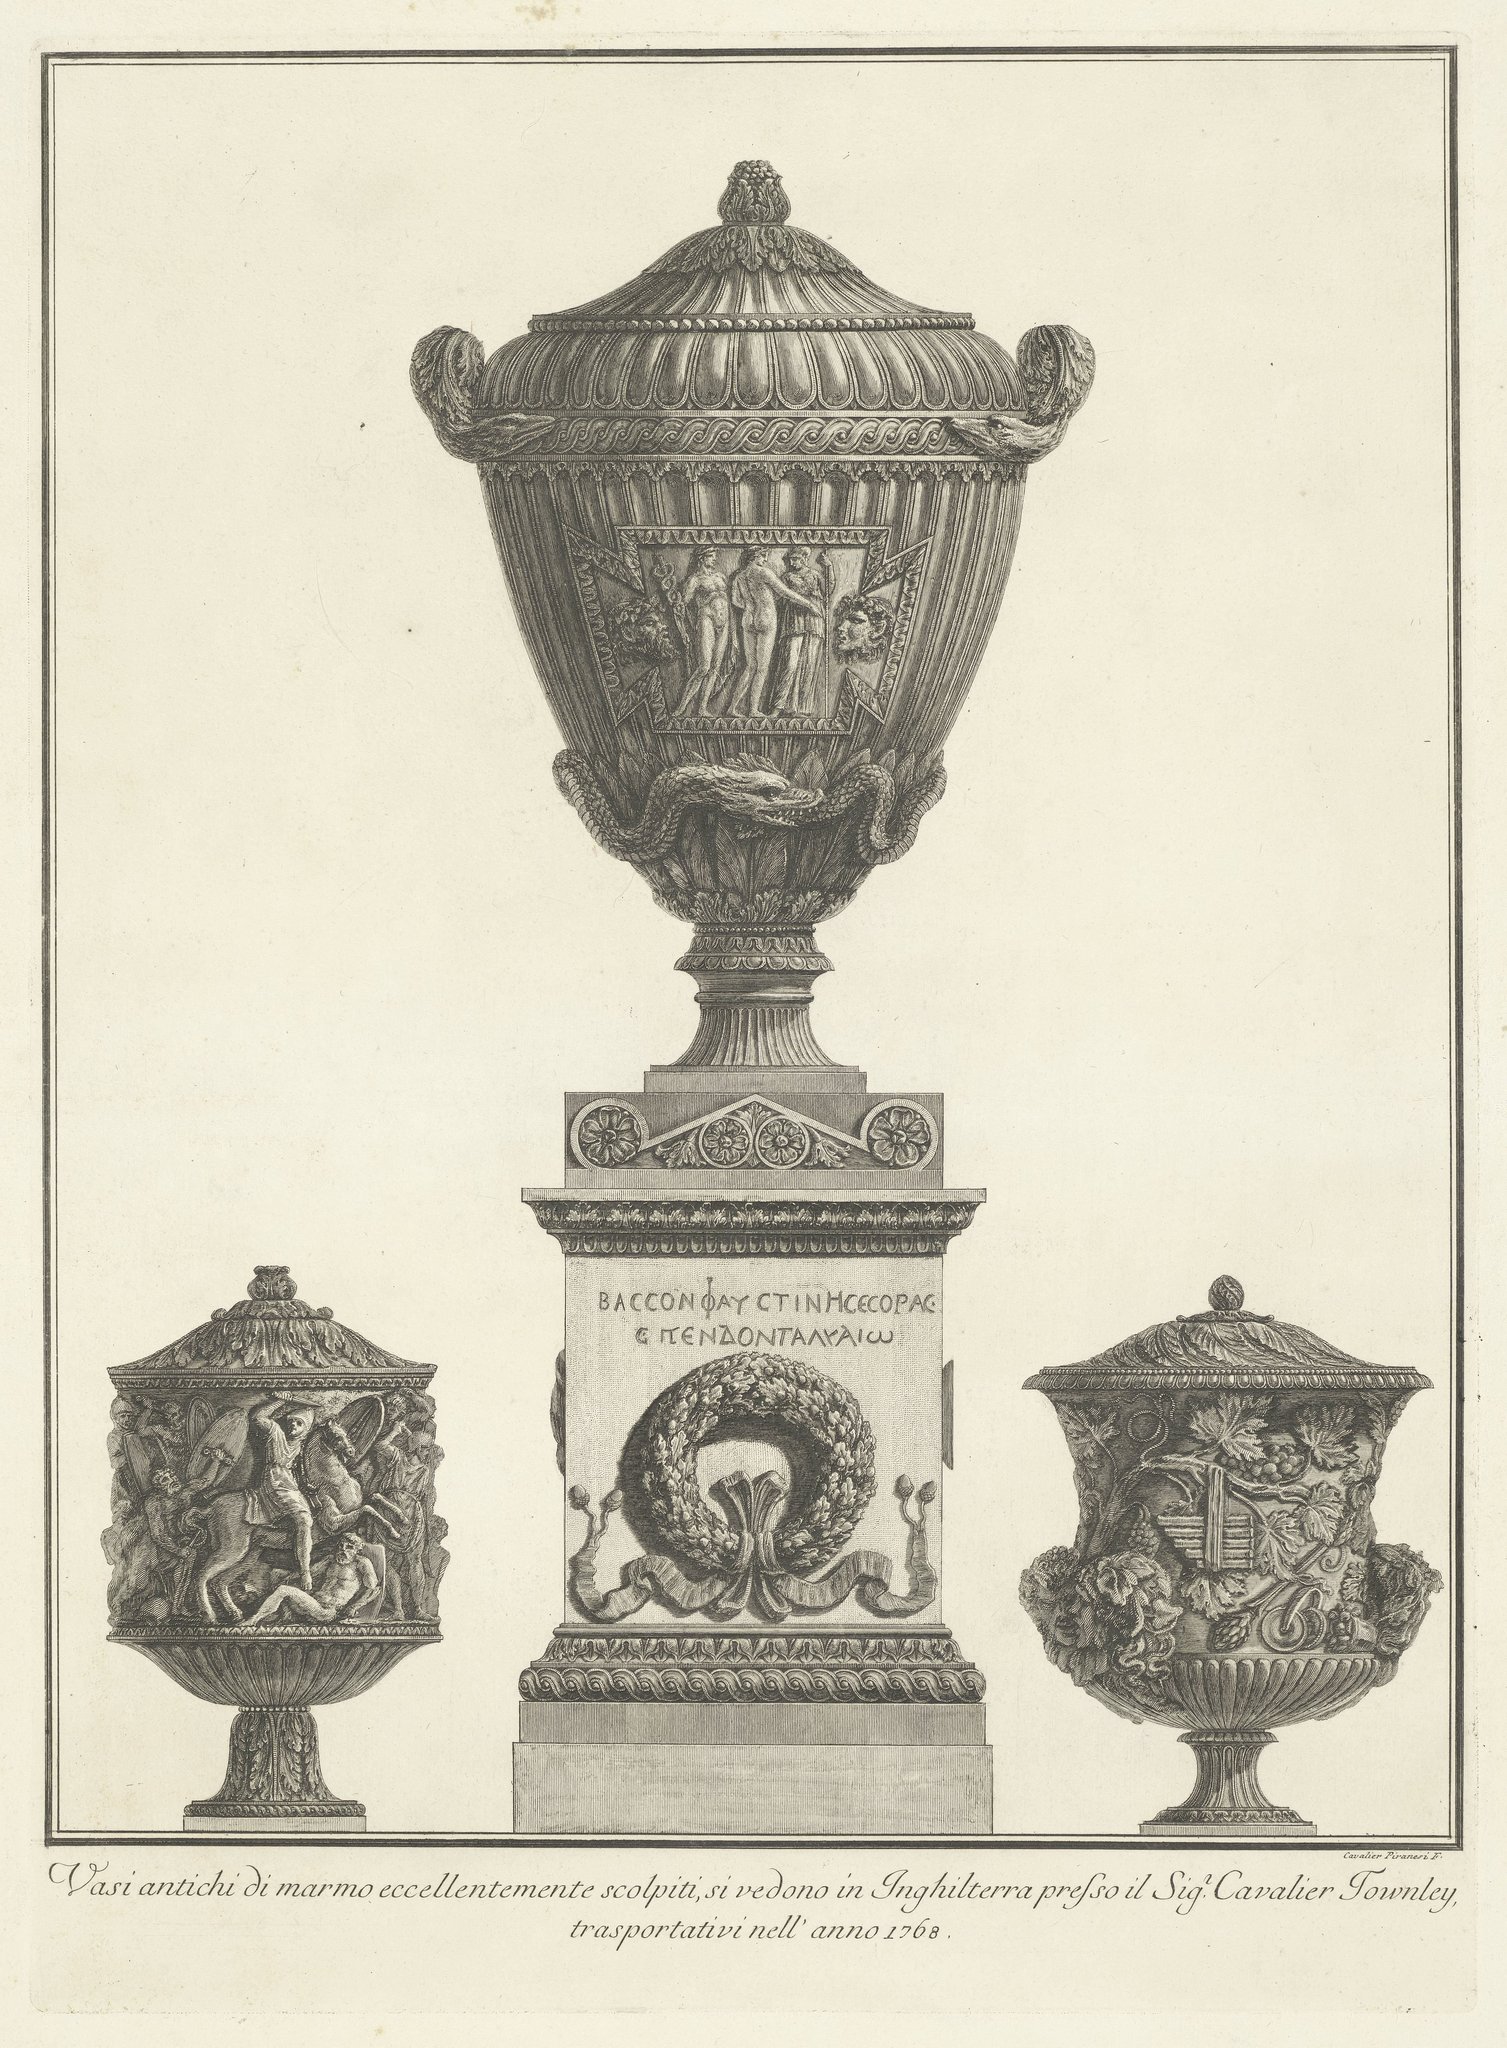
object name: print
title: Vasi, candelabri, cippi, sarcofagi, tripodi, lucerne, ed ornamenti antichi disegn. ed incisi dal cav. Gio. Batta Piranesi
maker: giovanni battista piranesi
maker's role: designer, draughtsman, print maker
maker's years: 1720-1778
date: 1778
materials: paper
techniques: etching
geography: rome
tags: vase ~ ornament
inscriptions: collector's mark: Lugt 2228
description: De 'Vasi'-reeks telt 110 prenten, verspreid over twee volumes met elk een eigen titelprent. Piranesi werd voor deze reeks geholpen door verschillende assistenten uit zijn werkplaats, waaronder zijn zoon Francesco die ook nog eens 8 platen toevoegde aan de reeks in 1779-1780.